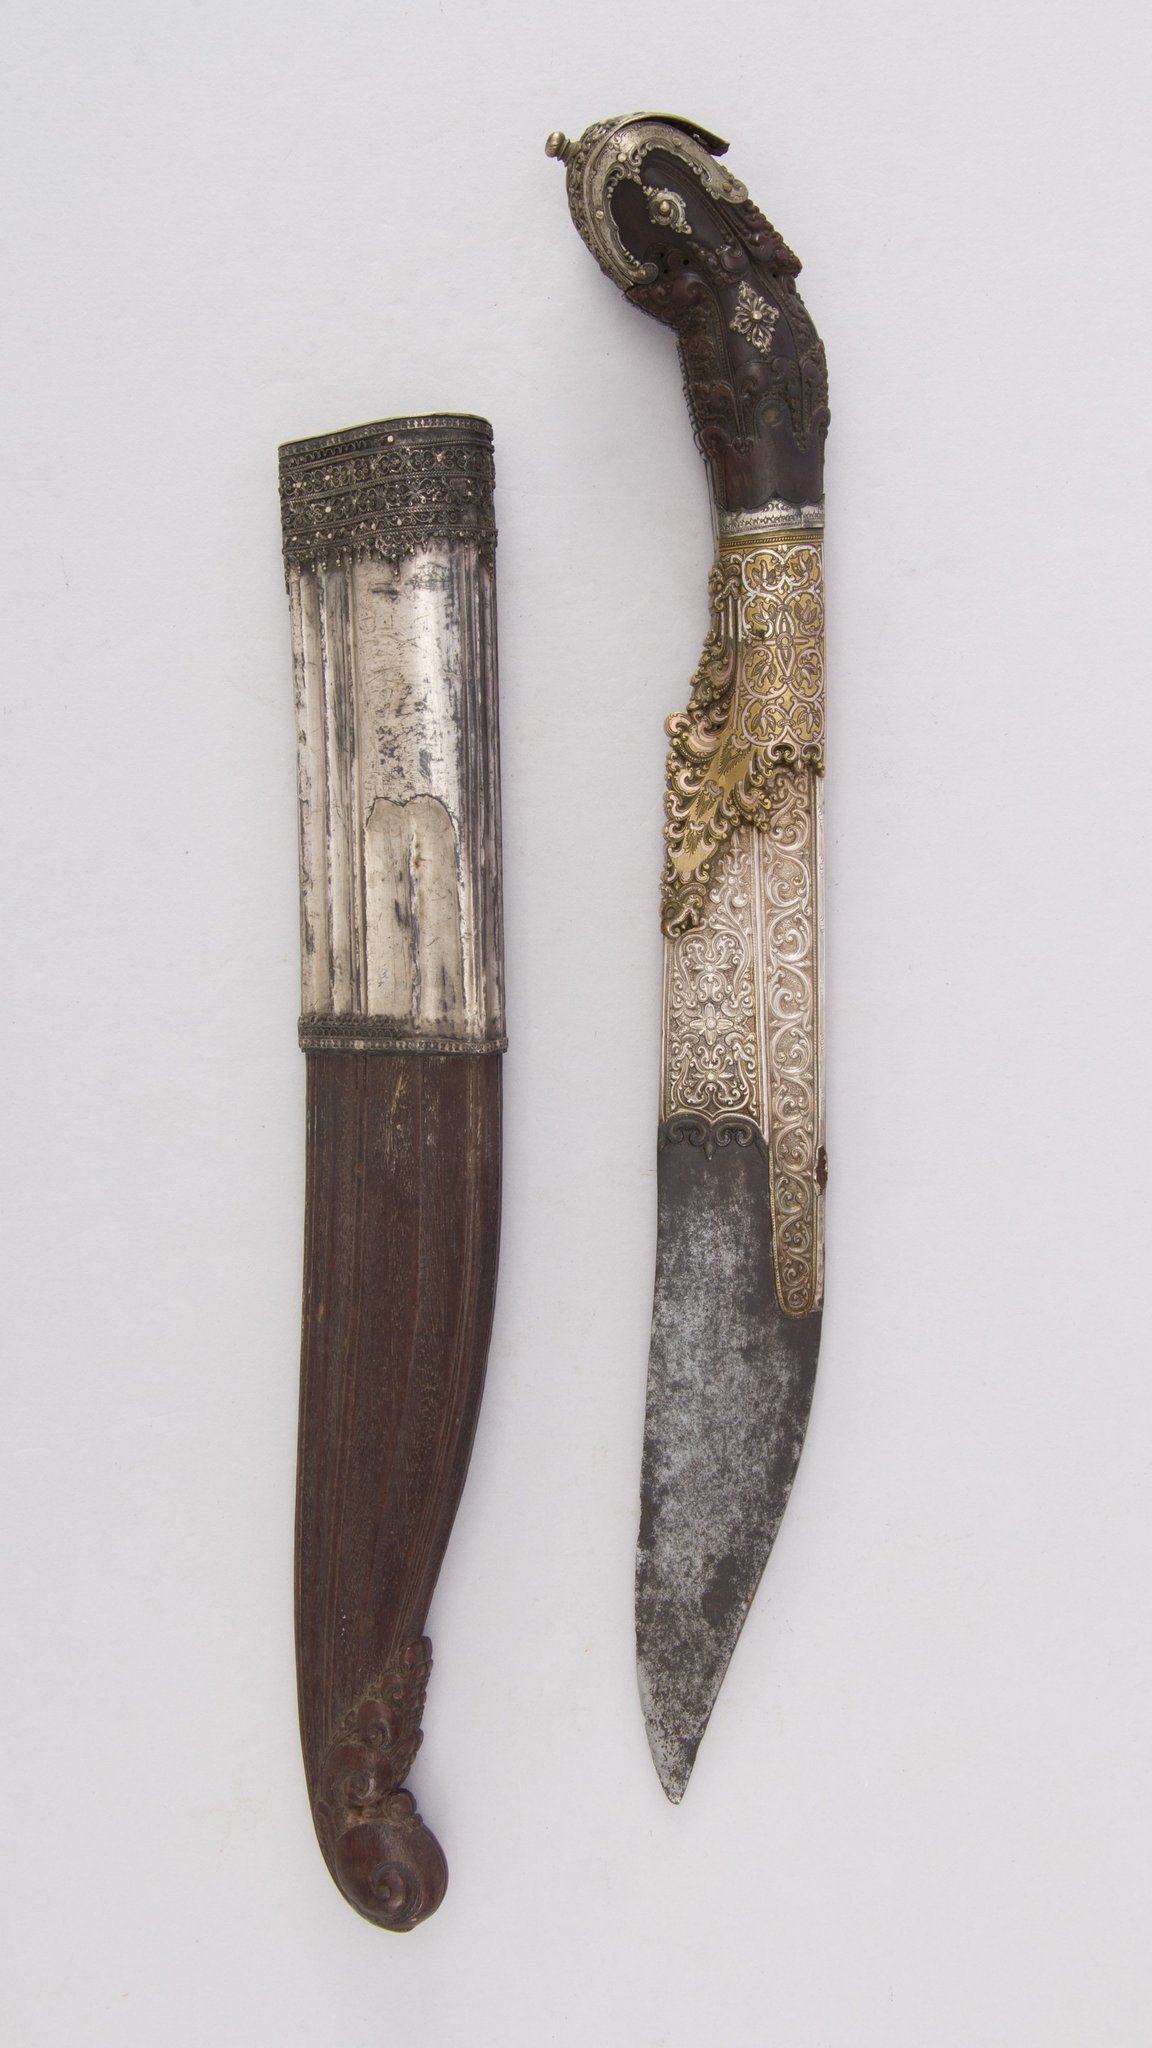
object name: knife piha kaetta with sheath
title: Knife (Piha Kaetta) with Sheath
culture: sri lankan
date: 1701-1900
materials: brass, silver, steel, wood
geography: sri lanka